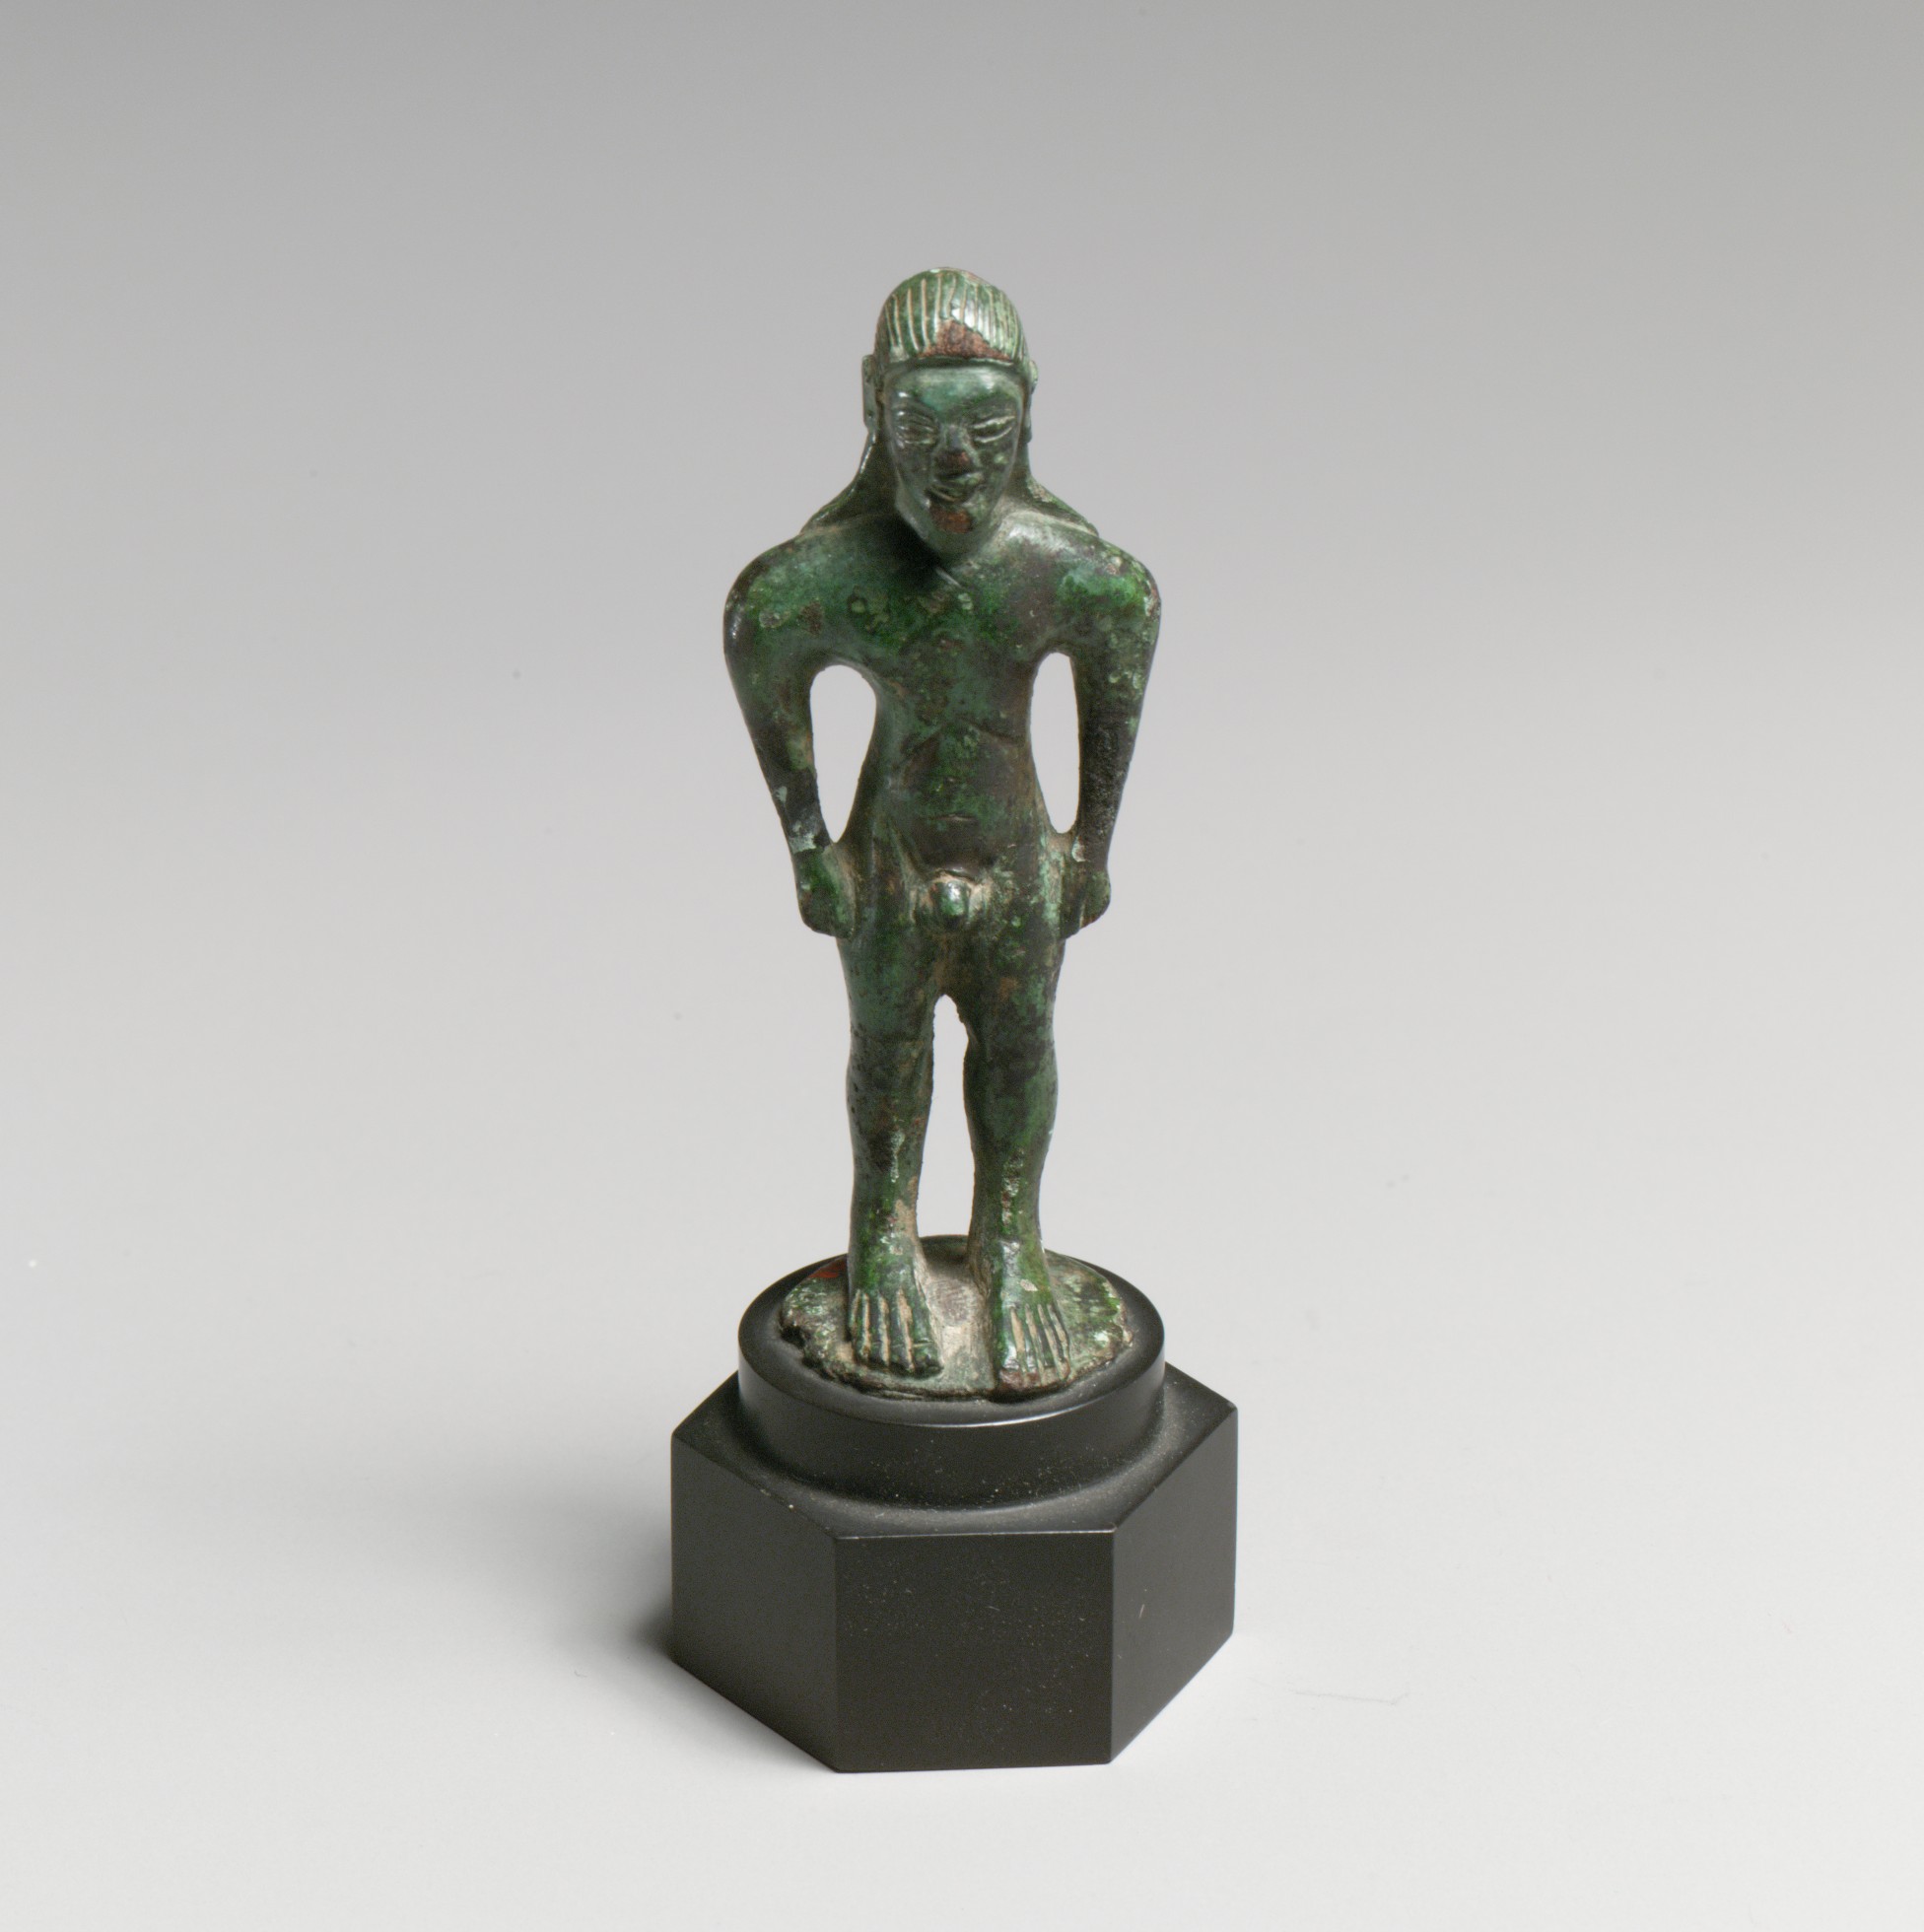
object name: statuette of a youth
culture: etruscan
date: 600-501 BCE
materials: bronze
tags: male nudes